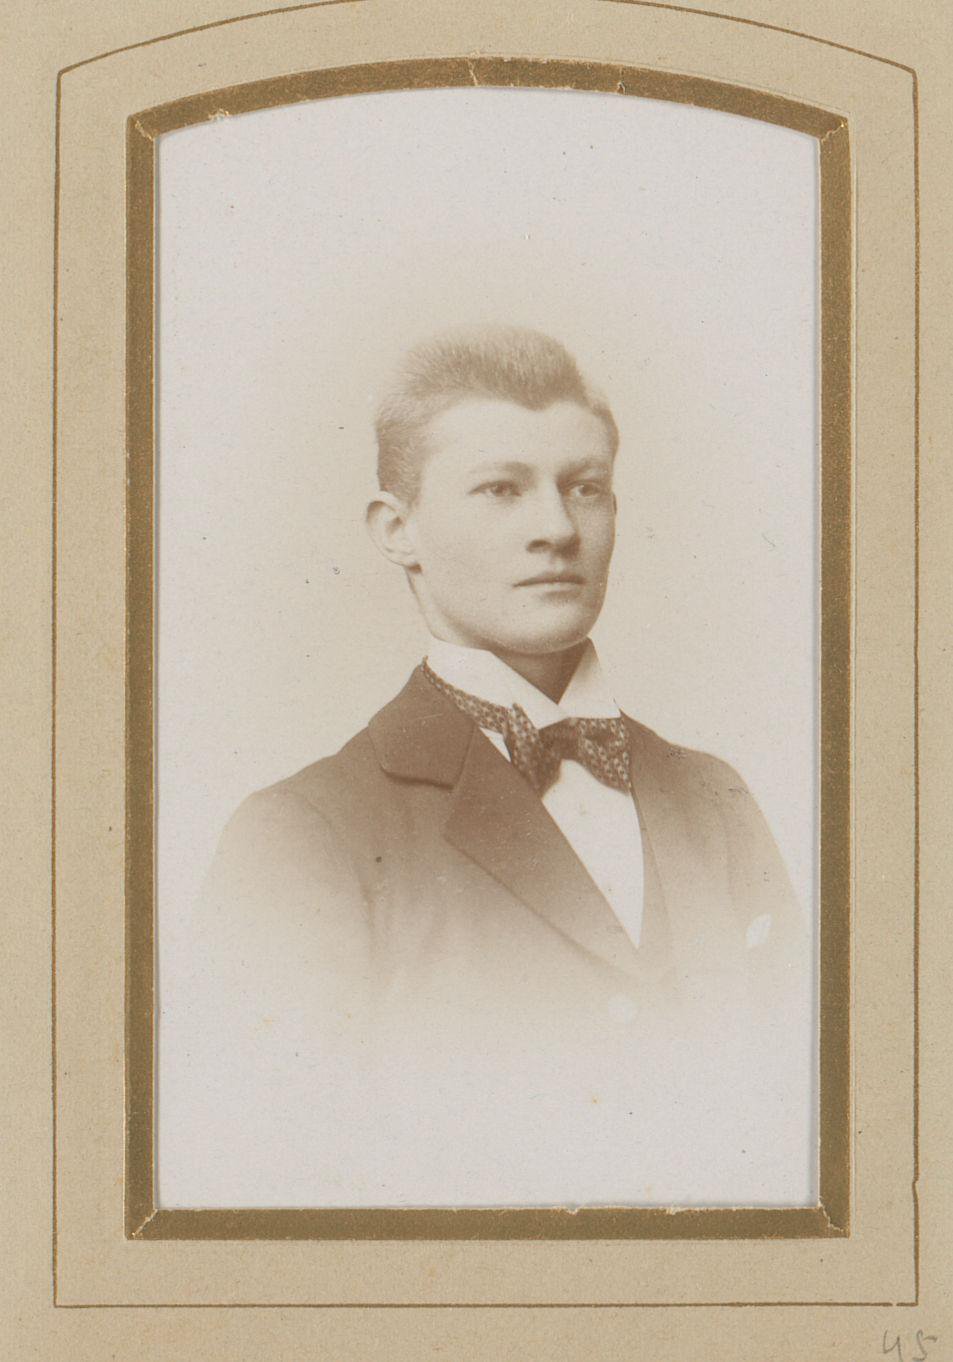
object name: photograph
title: Studioportret van Dolph Abendanon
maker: henri de louw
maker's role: fotograaf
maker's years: 1851-1944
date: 1880-1920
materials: paper, photographic support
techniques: photography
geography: the hague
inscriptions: inscription: ‘Dolph’